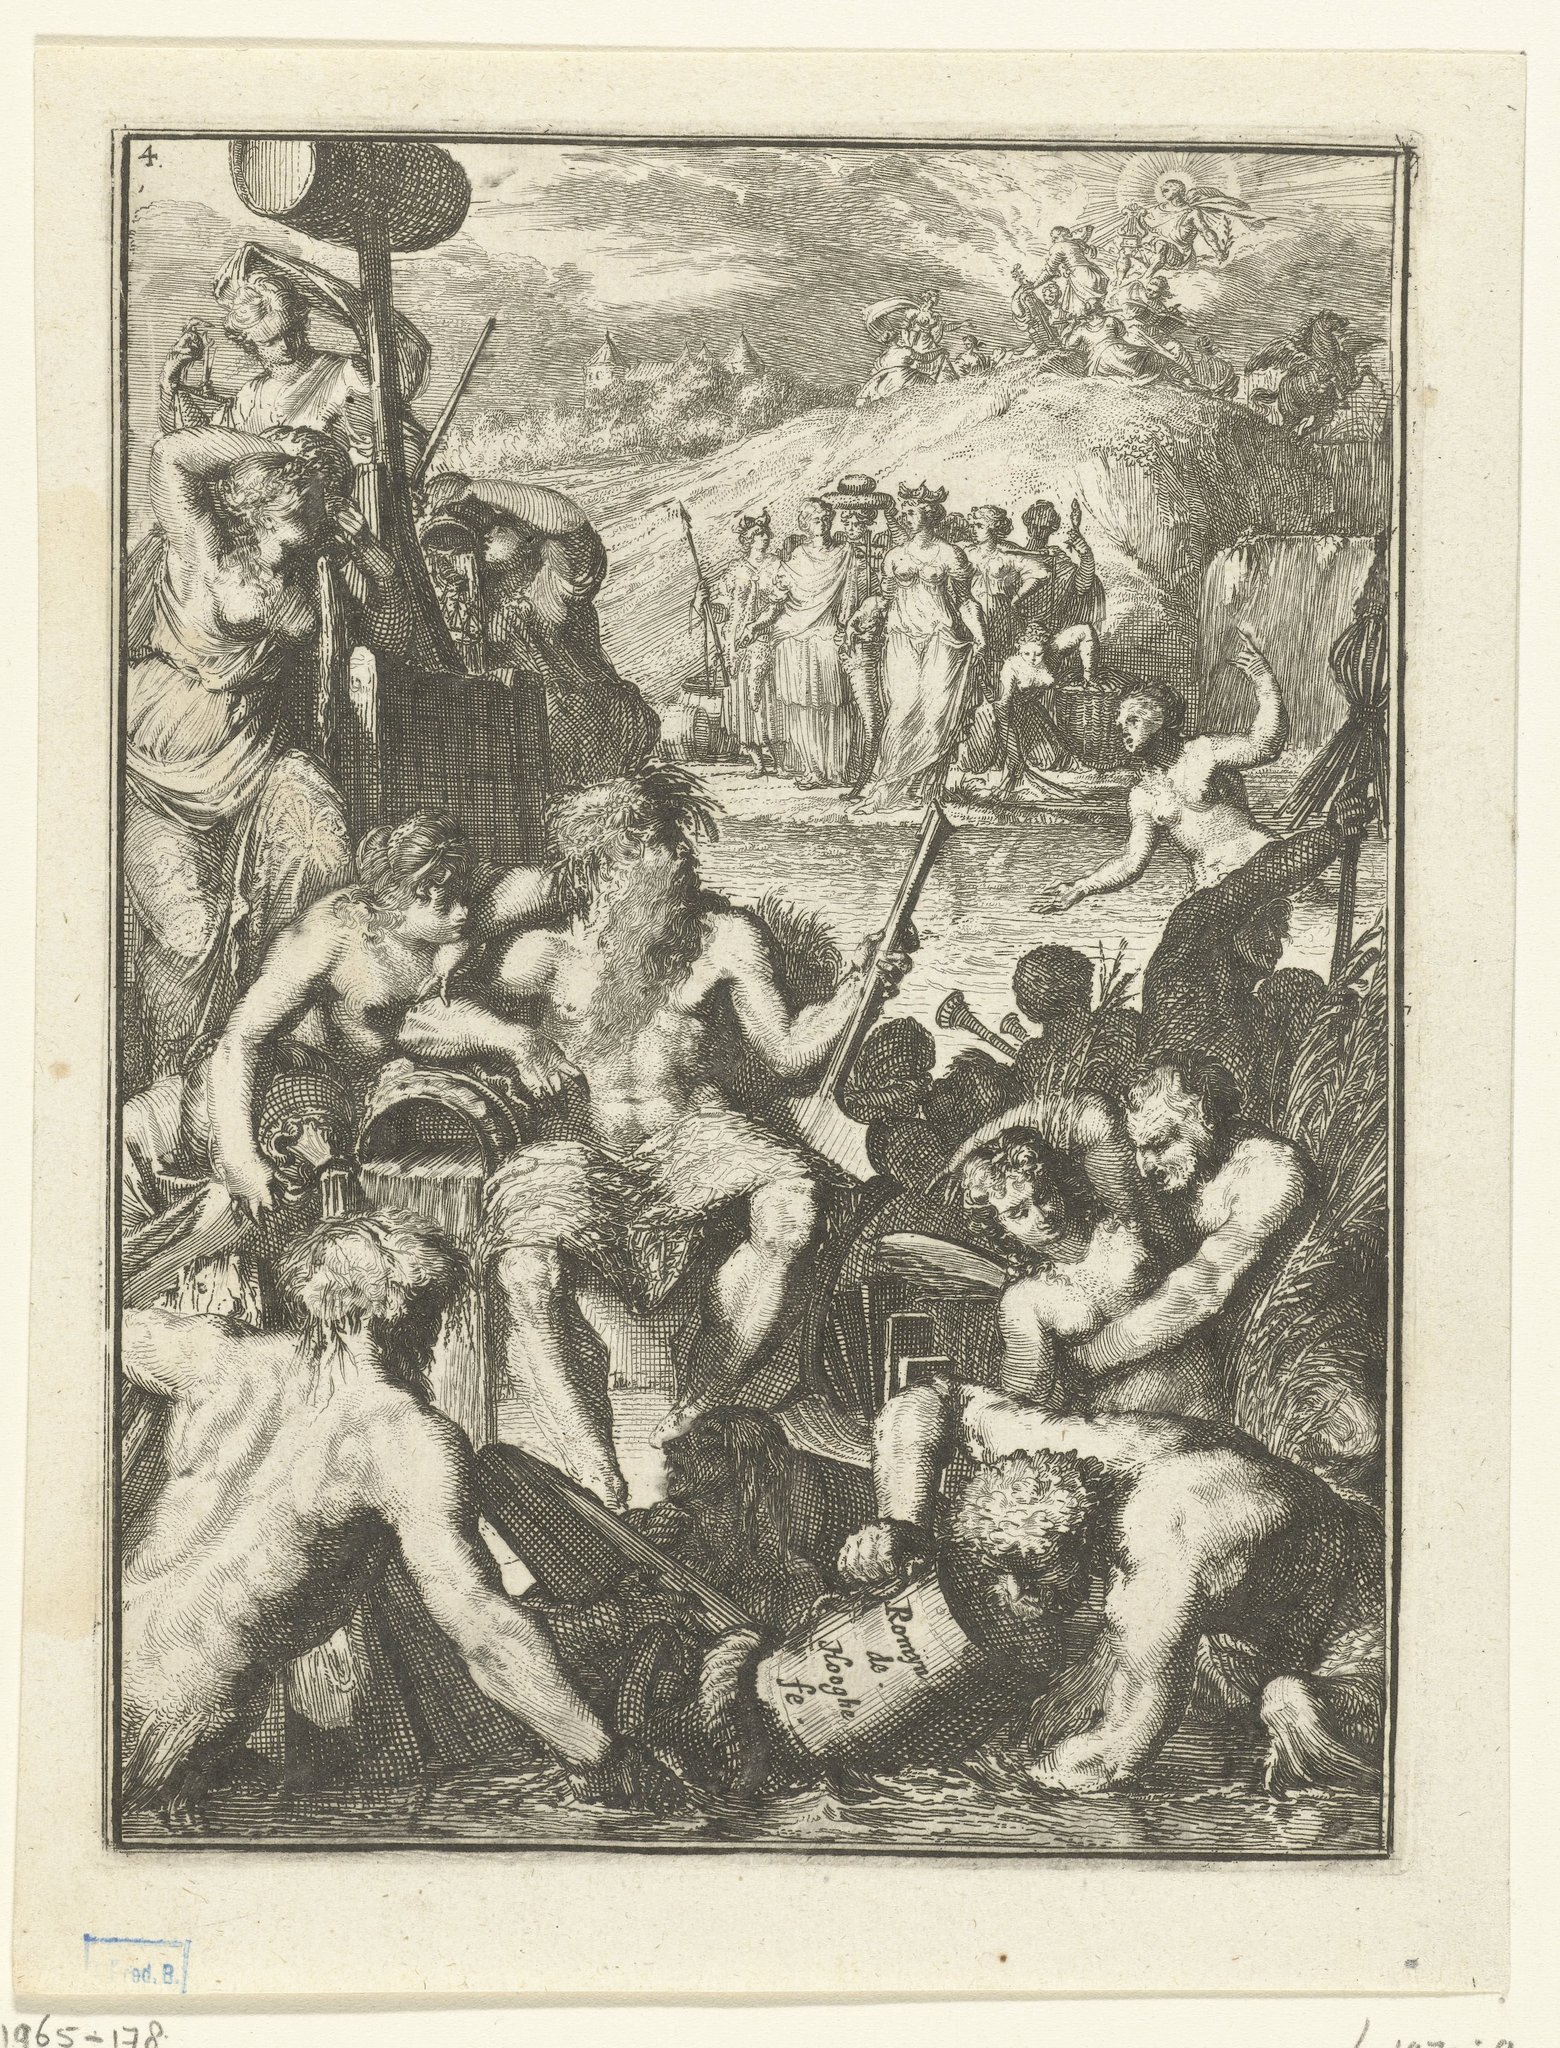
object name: book illustration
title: Titelprent van Boek 4 van De Ystroom (1671) van Antonides van der Goes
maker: romeyn de hooghe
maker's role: draughtsman, goldsmith, painter, print maker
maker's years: 1645-1708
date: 1671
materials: paper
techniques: etching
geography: netherlands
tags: river personified, 'fiumi' (ripa), gods of the waters: neptune and his environment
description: Titelprent van Boek 4 van De Ystroom (1671) van Antonides van der Goes. De riviergod van het IJ (Ystroomgod) zit in het midden van de voorstelling en kijkt om. De Zuiderzeegodin leunt op zijn schouder. Om hen heen verschillende allegorische figuren, zoals een watercentaur, Triton en de personificatie van de Zaan.